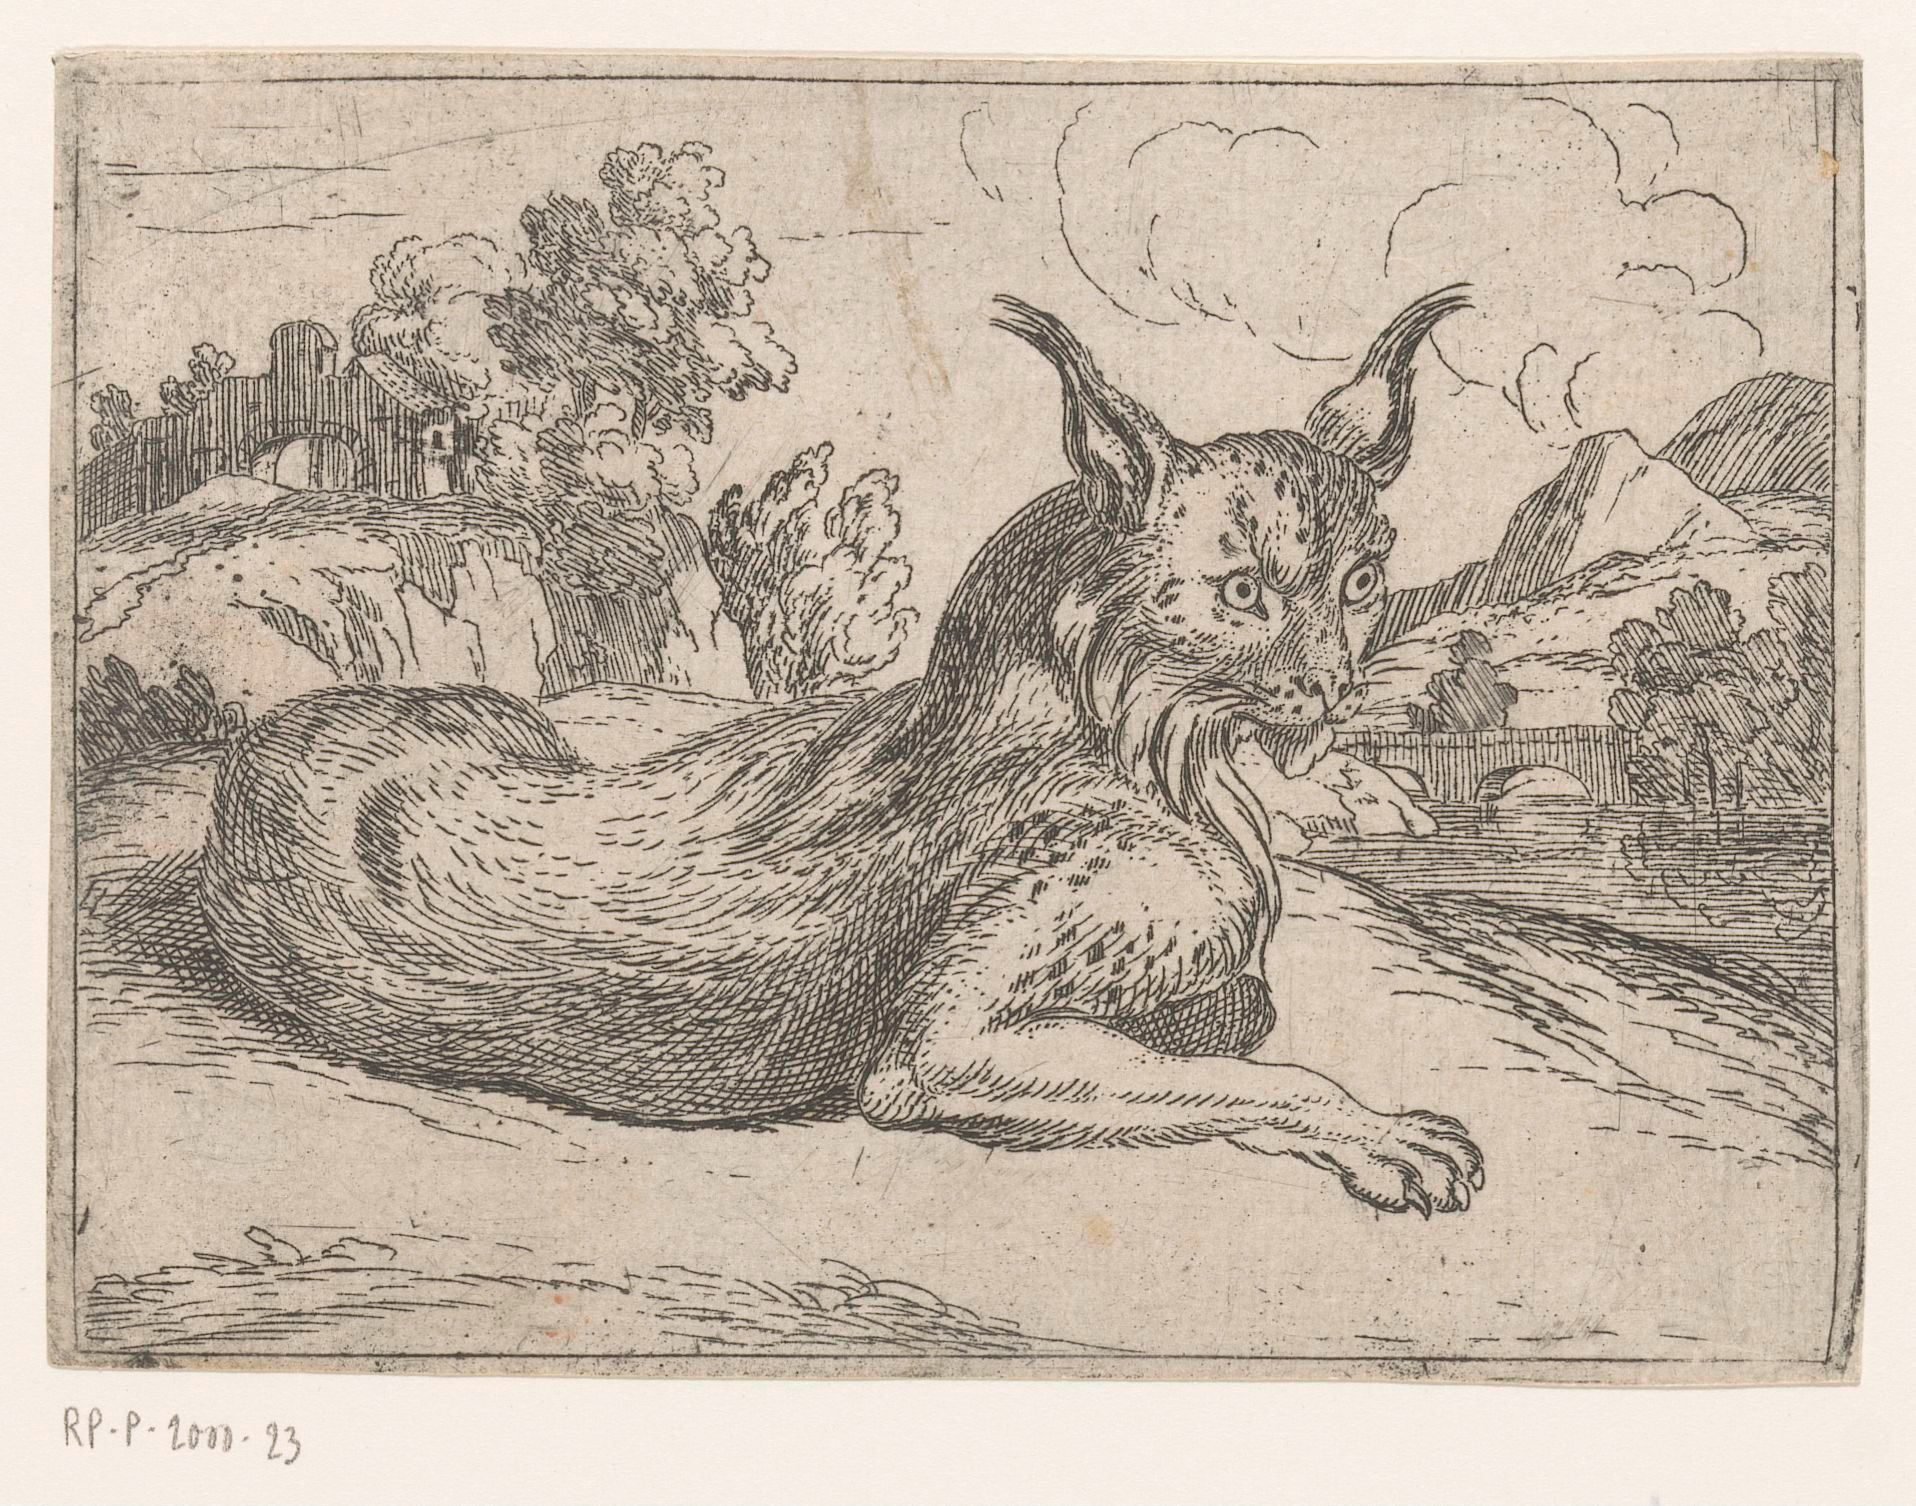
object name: print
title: Lynx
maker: jacques de fornazeris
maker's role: draughtsman, print maker, publisher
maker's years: 1585-1619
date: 1580-1590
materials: paper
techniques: etching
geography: italy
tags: beasts of prey, predatory animals: lynx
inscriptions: collector's mark: Lugt 2228, collector's mark: Lugt 2760